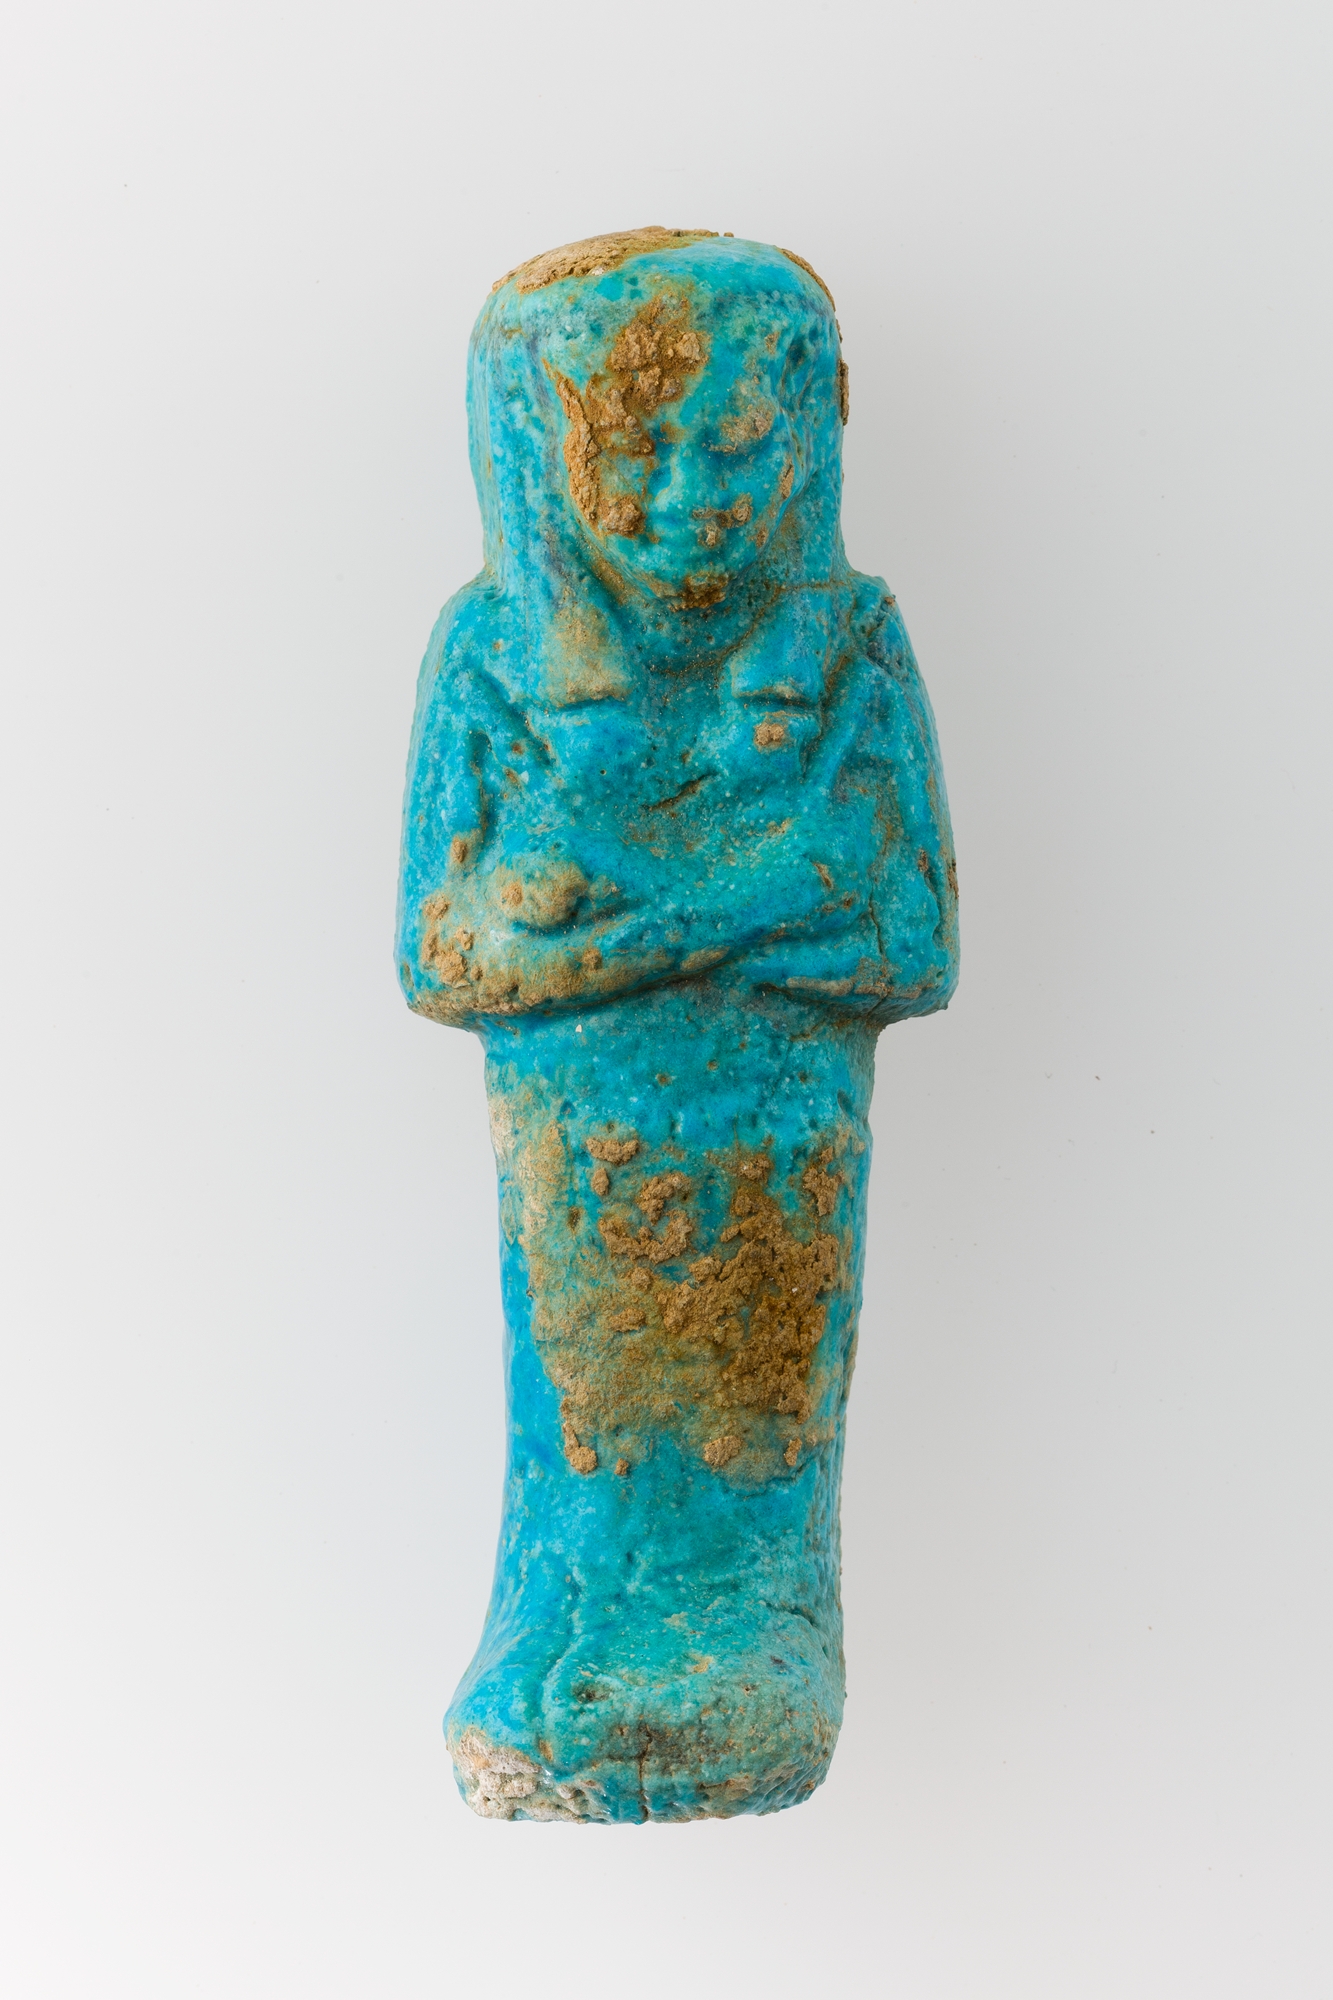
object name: shabti, henettawy c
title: Worker Shabti of Henettawy (C), Daughter of Isetemkheb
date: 990-970 BCE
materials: faience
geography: egypt